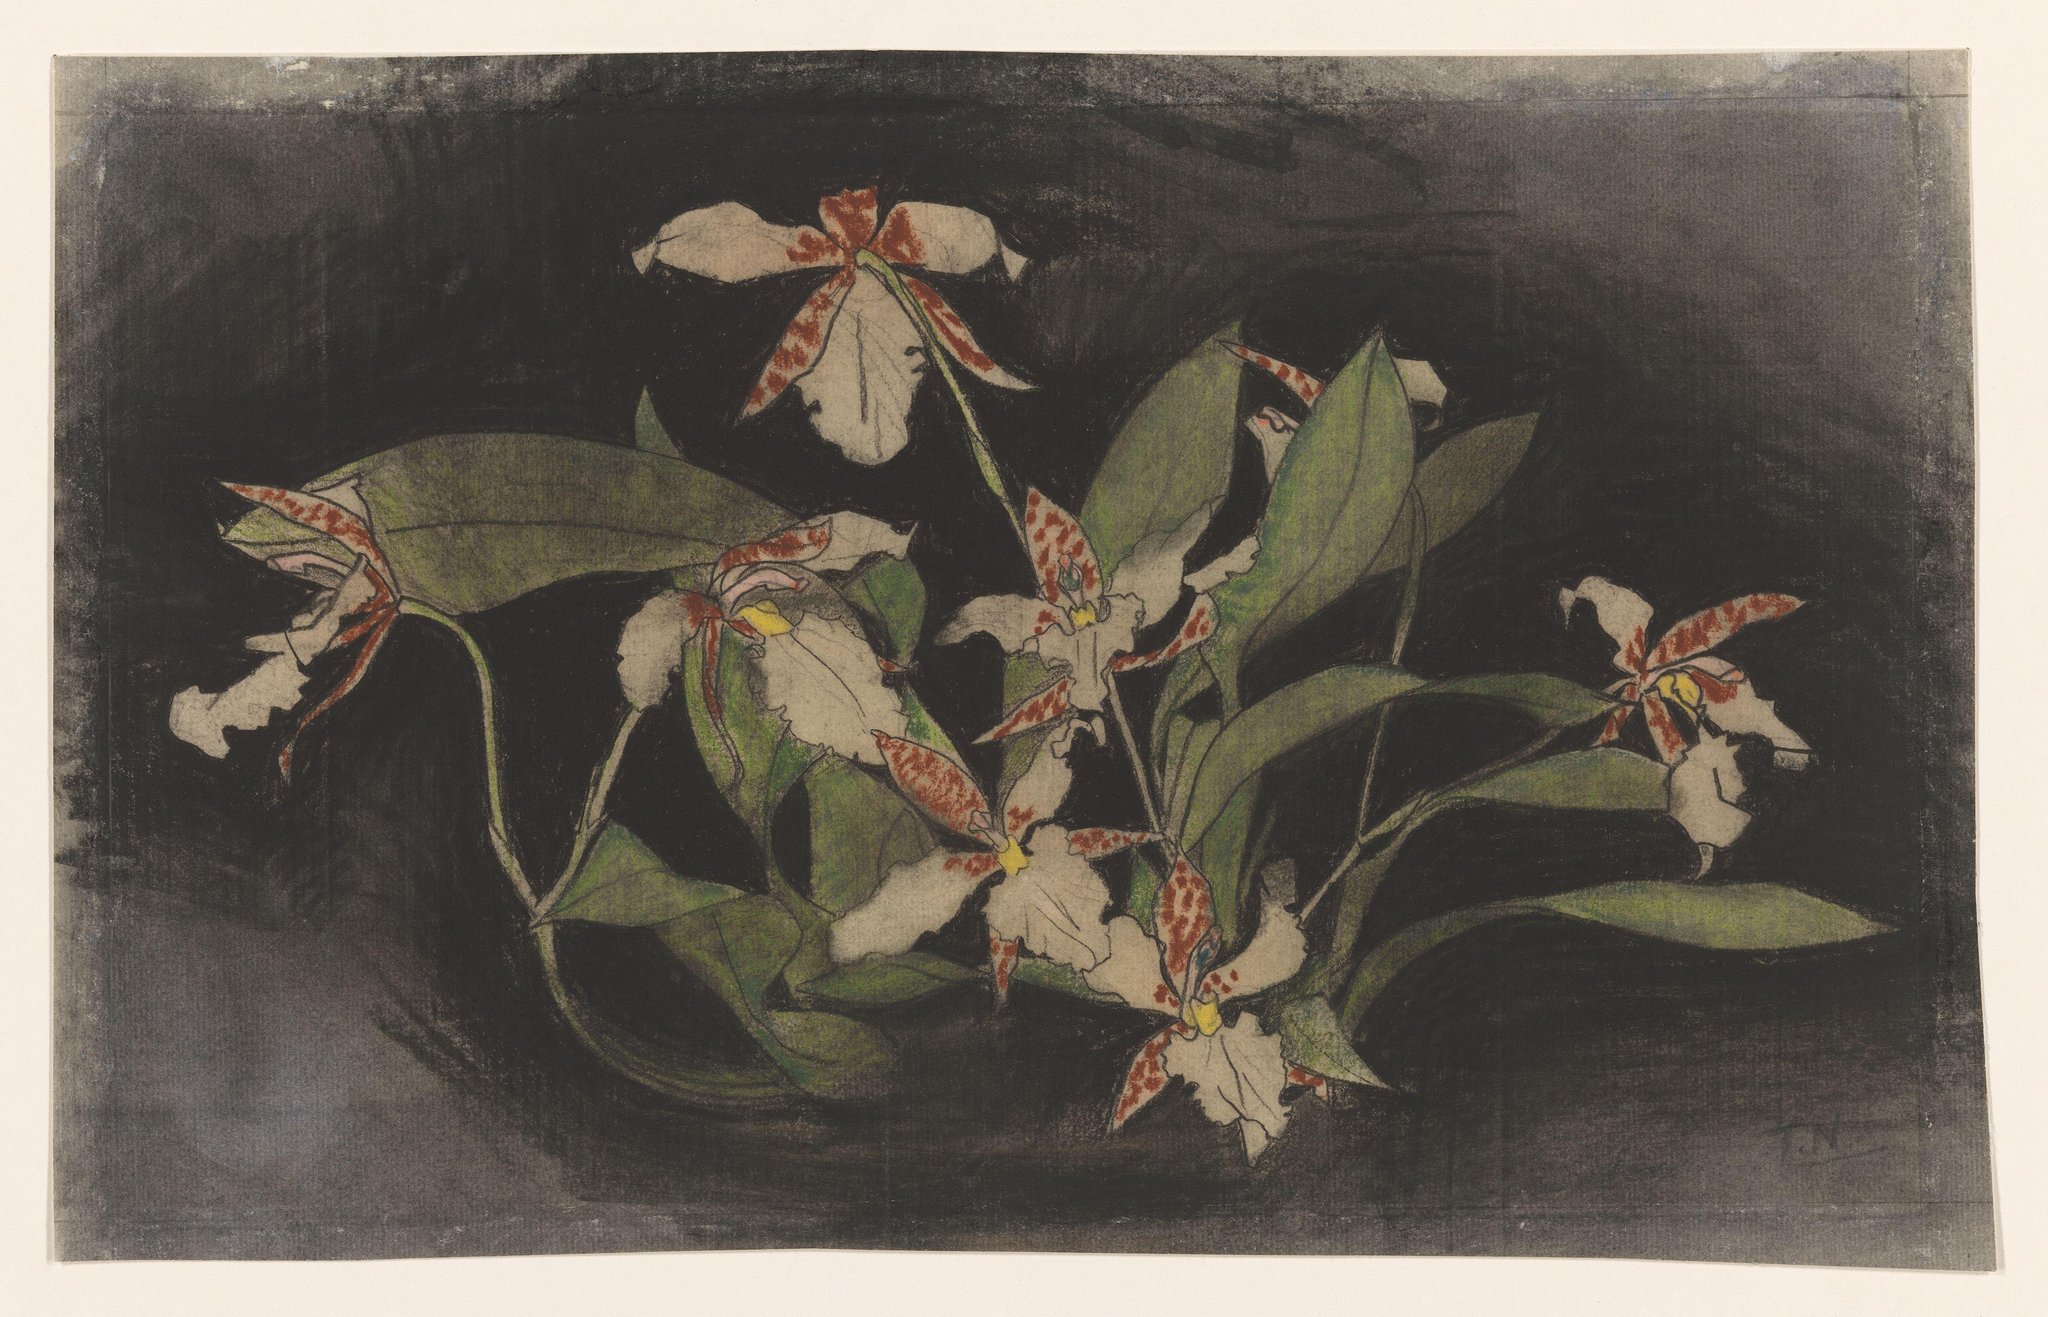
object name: drawing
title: Bloeiende orchideeëntak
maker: theo nieuwenhuis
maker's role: designer, draughtsman, print maker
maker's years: 1866-1951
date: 1876-1951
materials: chalk, paper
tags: flowers: orchid